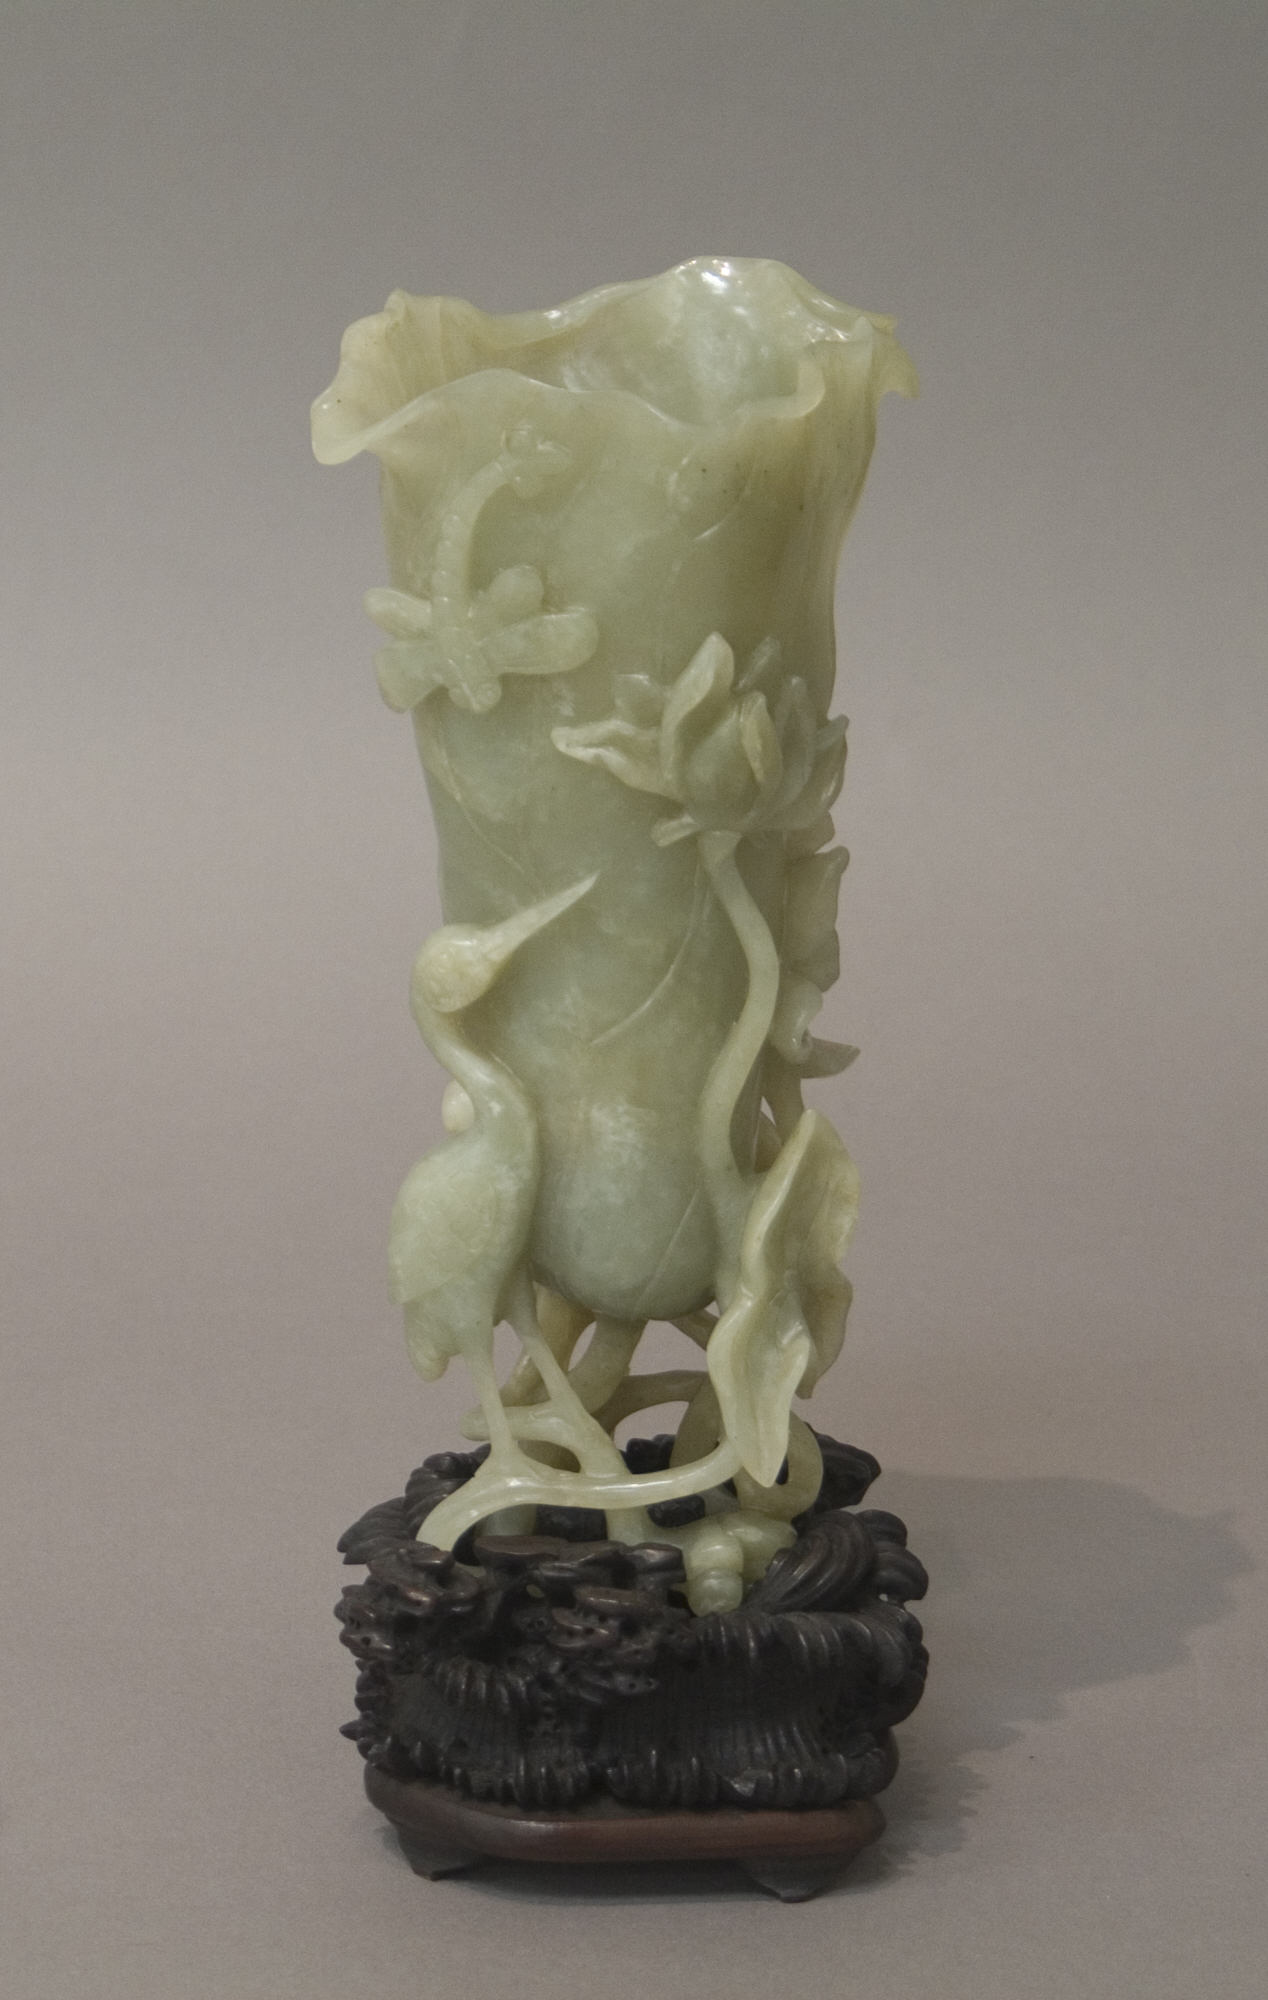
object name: flower vase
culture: chinese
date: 1662-1722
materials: jade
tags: birds,flowers